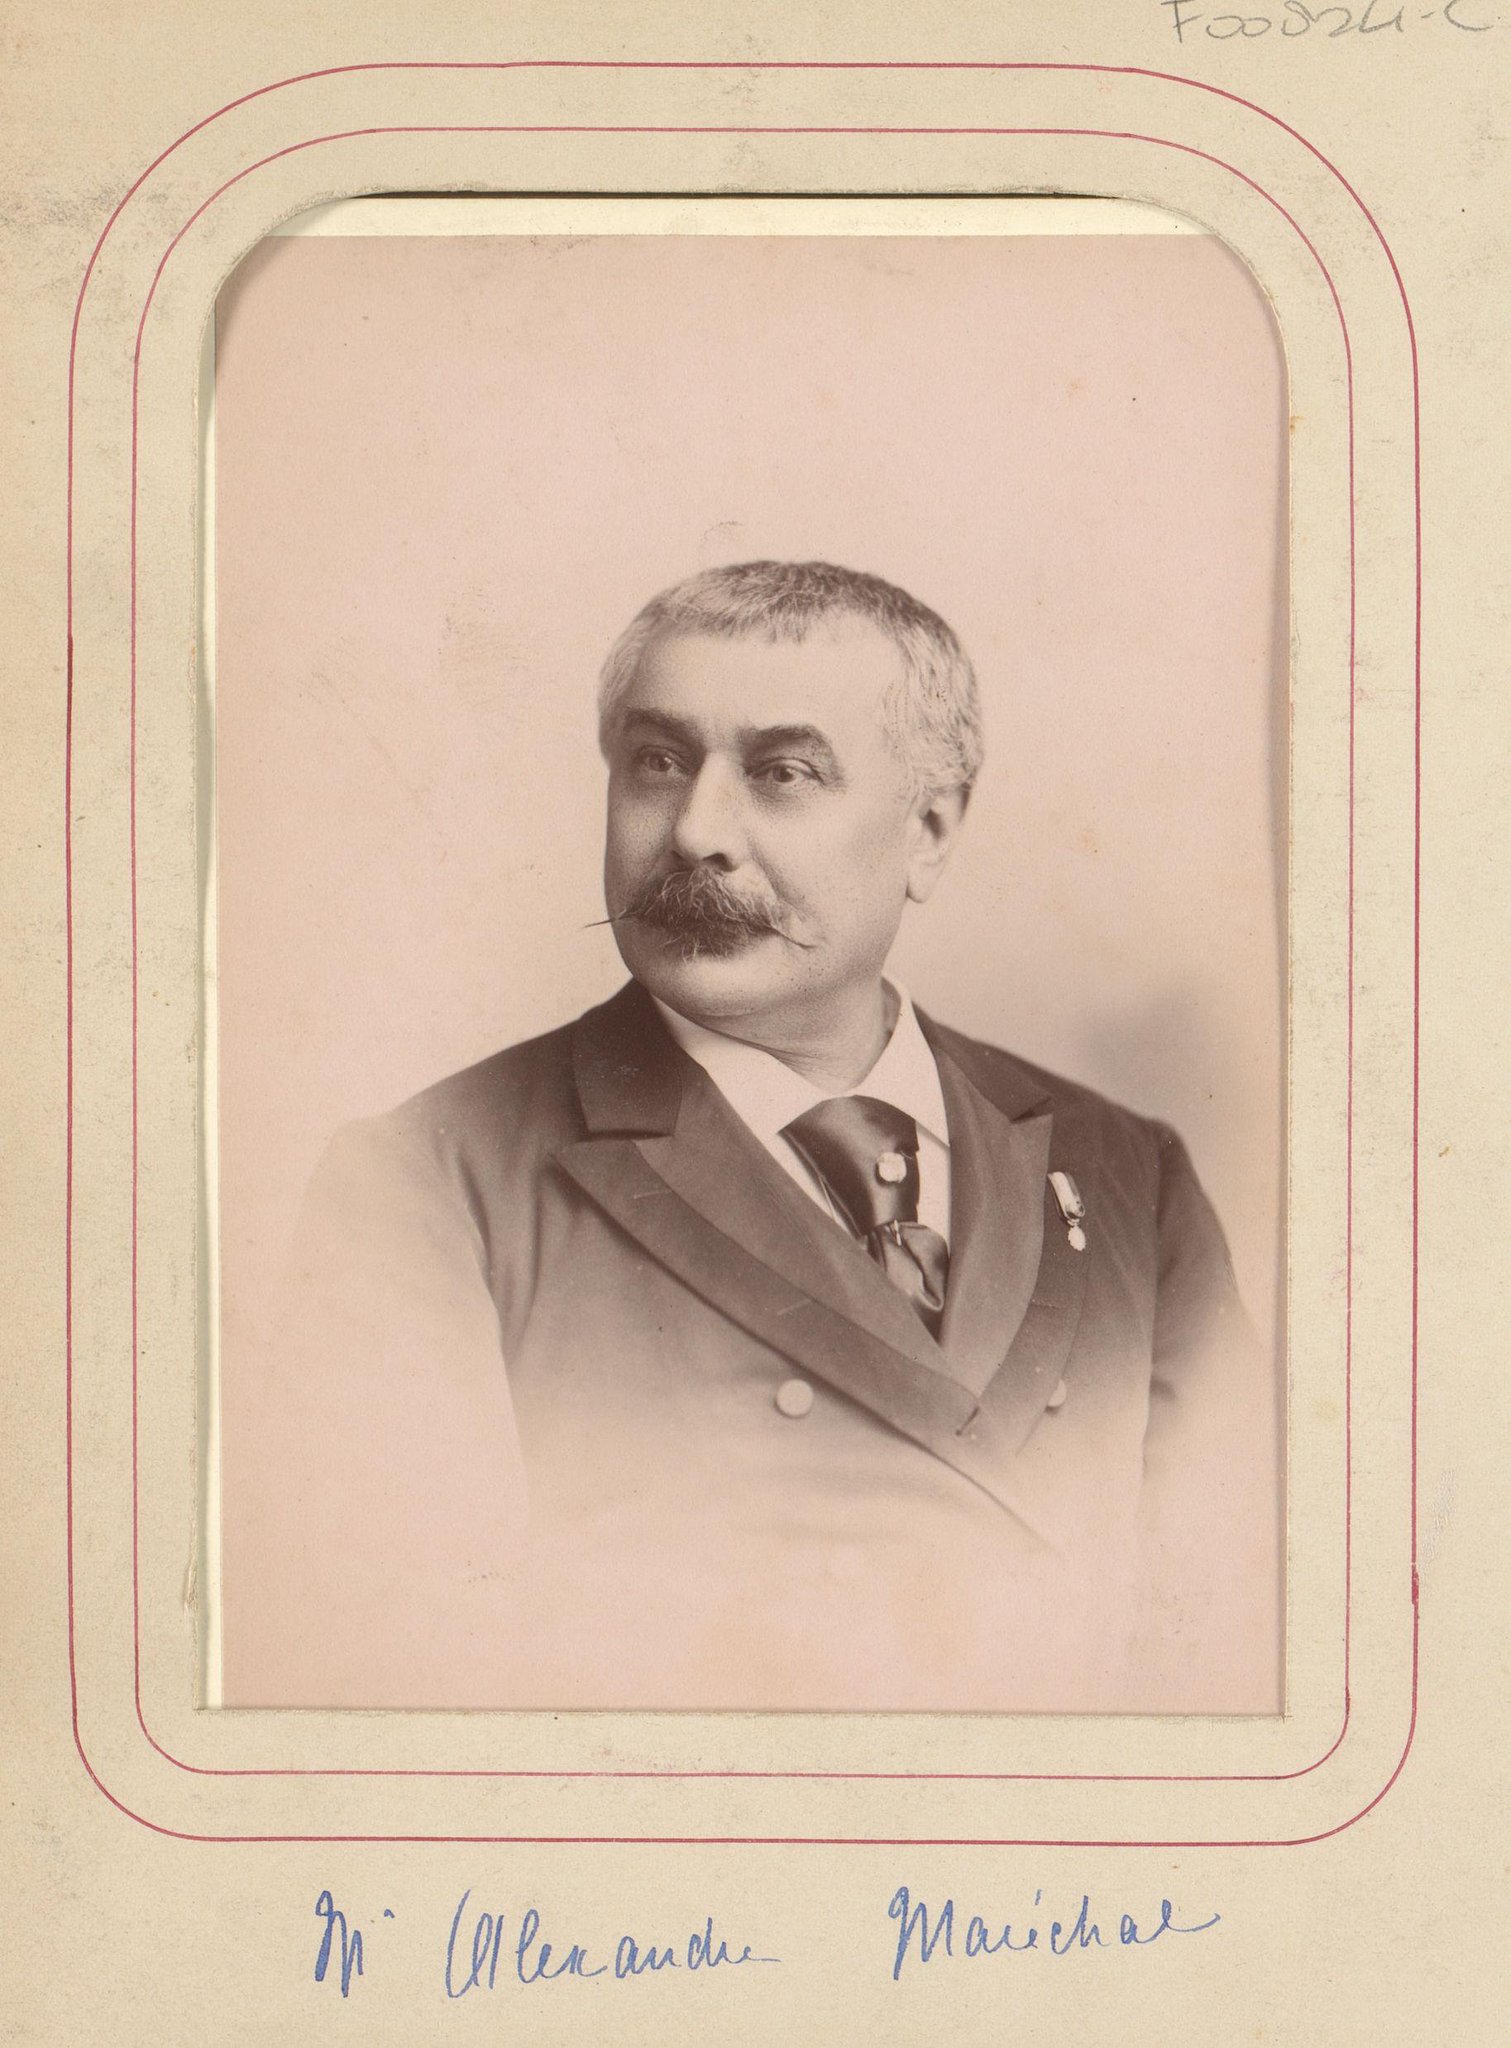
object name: photograph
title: Portret van Alexandre Maréchal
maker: jean-marie pipaud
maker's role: fotograaf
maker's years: 1847-1924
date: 1804-1894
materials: cardboard, paper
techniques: albumen print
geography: nantes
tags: adult man, historical persons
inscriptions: address: ‘11, Rue Crébillon, 11/ Nantes’, inscription: ‘A Mon cher/ et Jeune ami/ Gabriel Griendoyen [?]/ [...]/ Avril 1894’, inscription: ‘médaille de vermell/ 1er PRIX/ NANTES 1882/ Tous les Clichés sont conservés/ D. HUTINET, PARIS.’